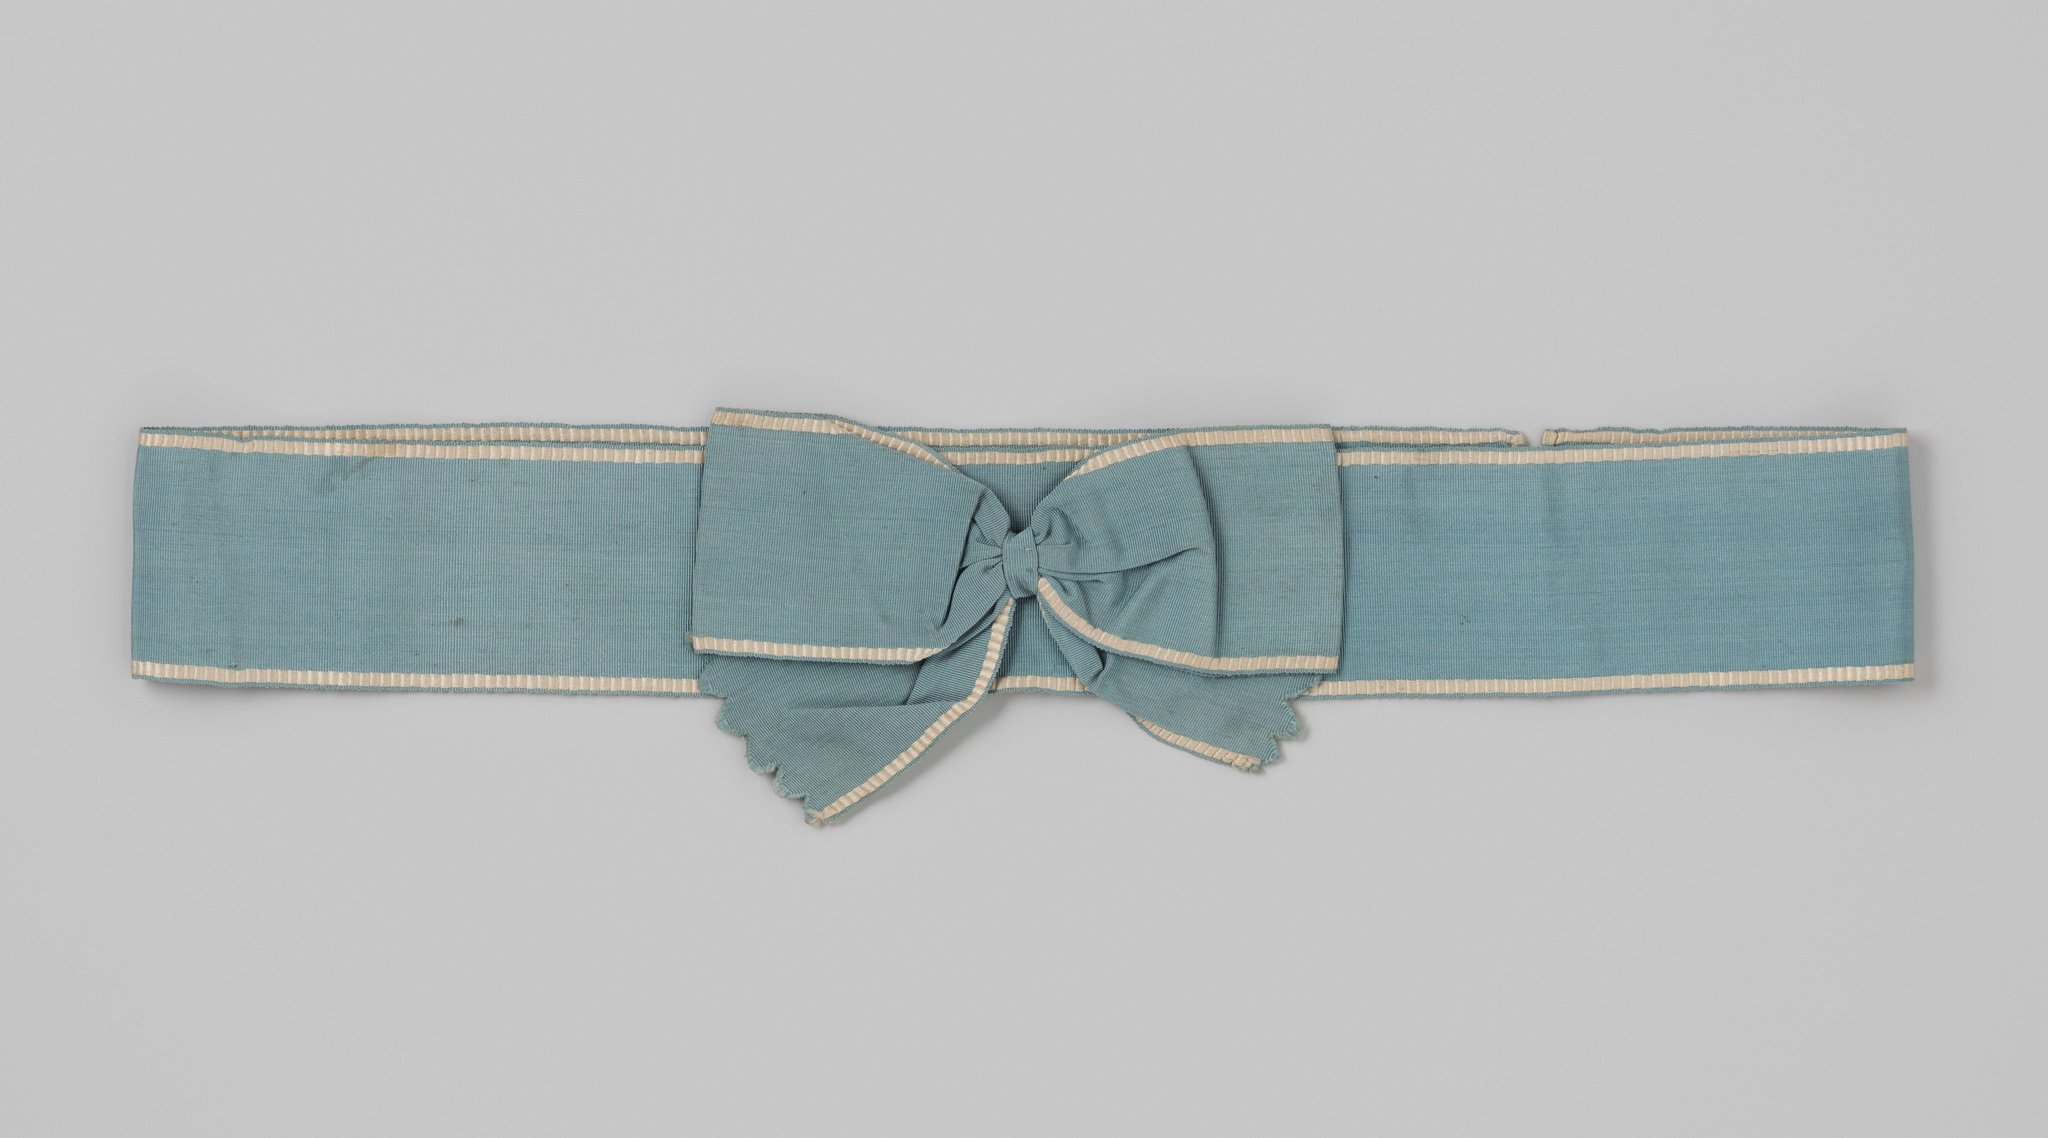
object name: childrenswear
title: Lint van lichtblauwe ripszijde, met opgenaaide strik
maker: Anonymous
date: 1800-1825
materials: silk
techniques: rib binding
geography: western europe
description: Lint van lichtblauwe ripszijde, dat langs de kanten is versierd met een geweven of geborduurde witte streep. Op het lint is een strik genaaid.